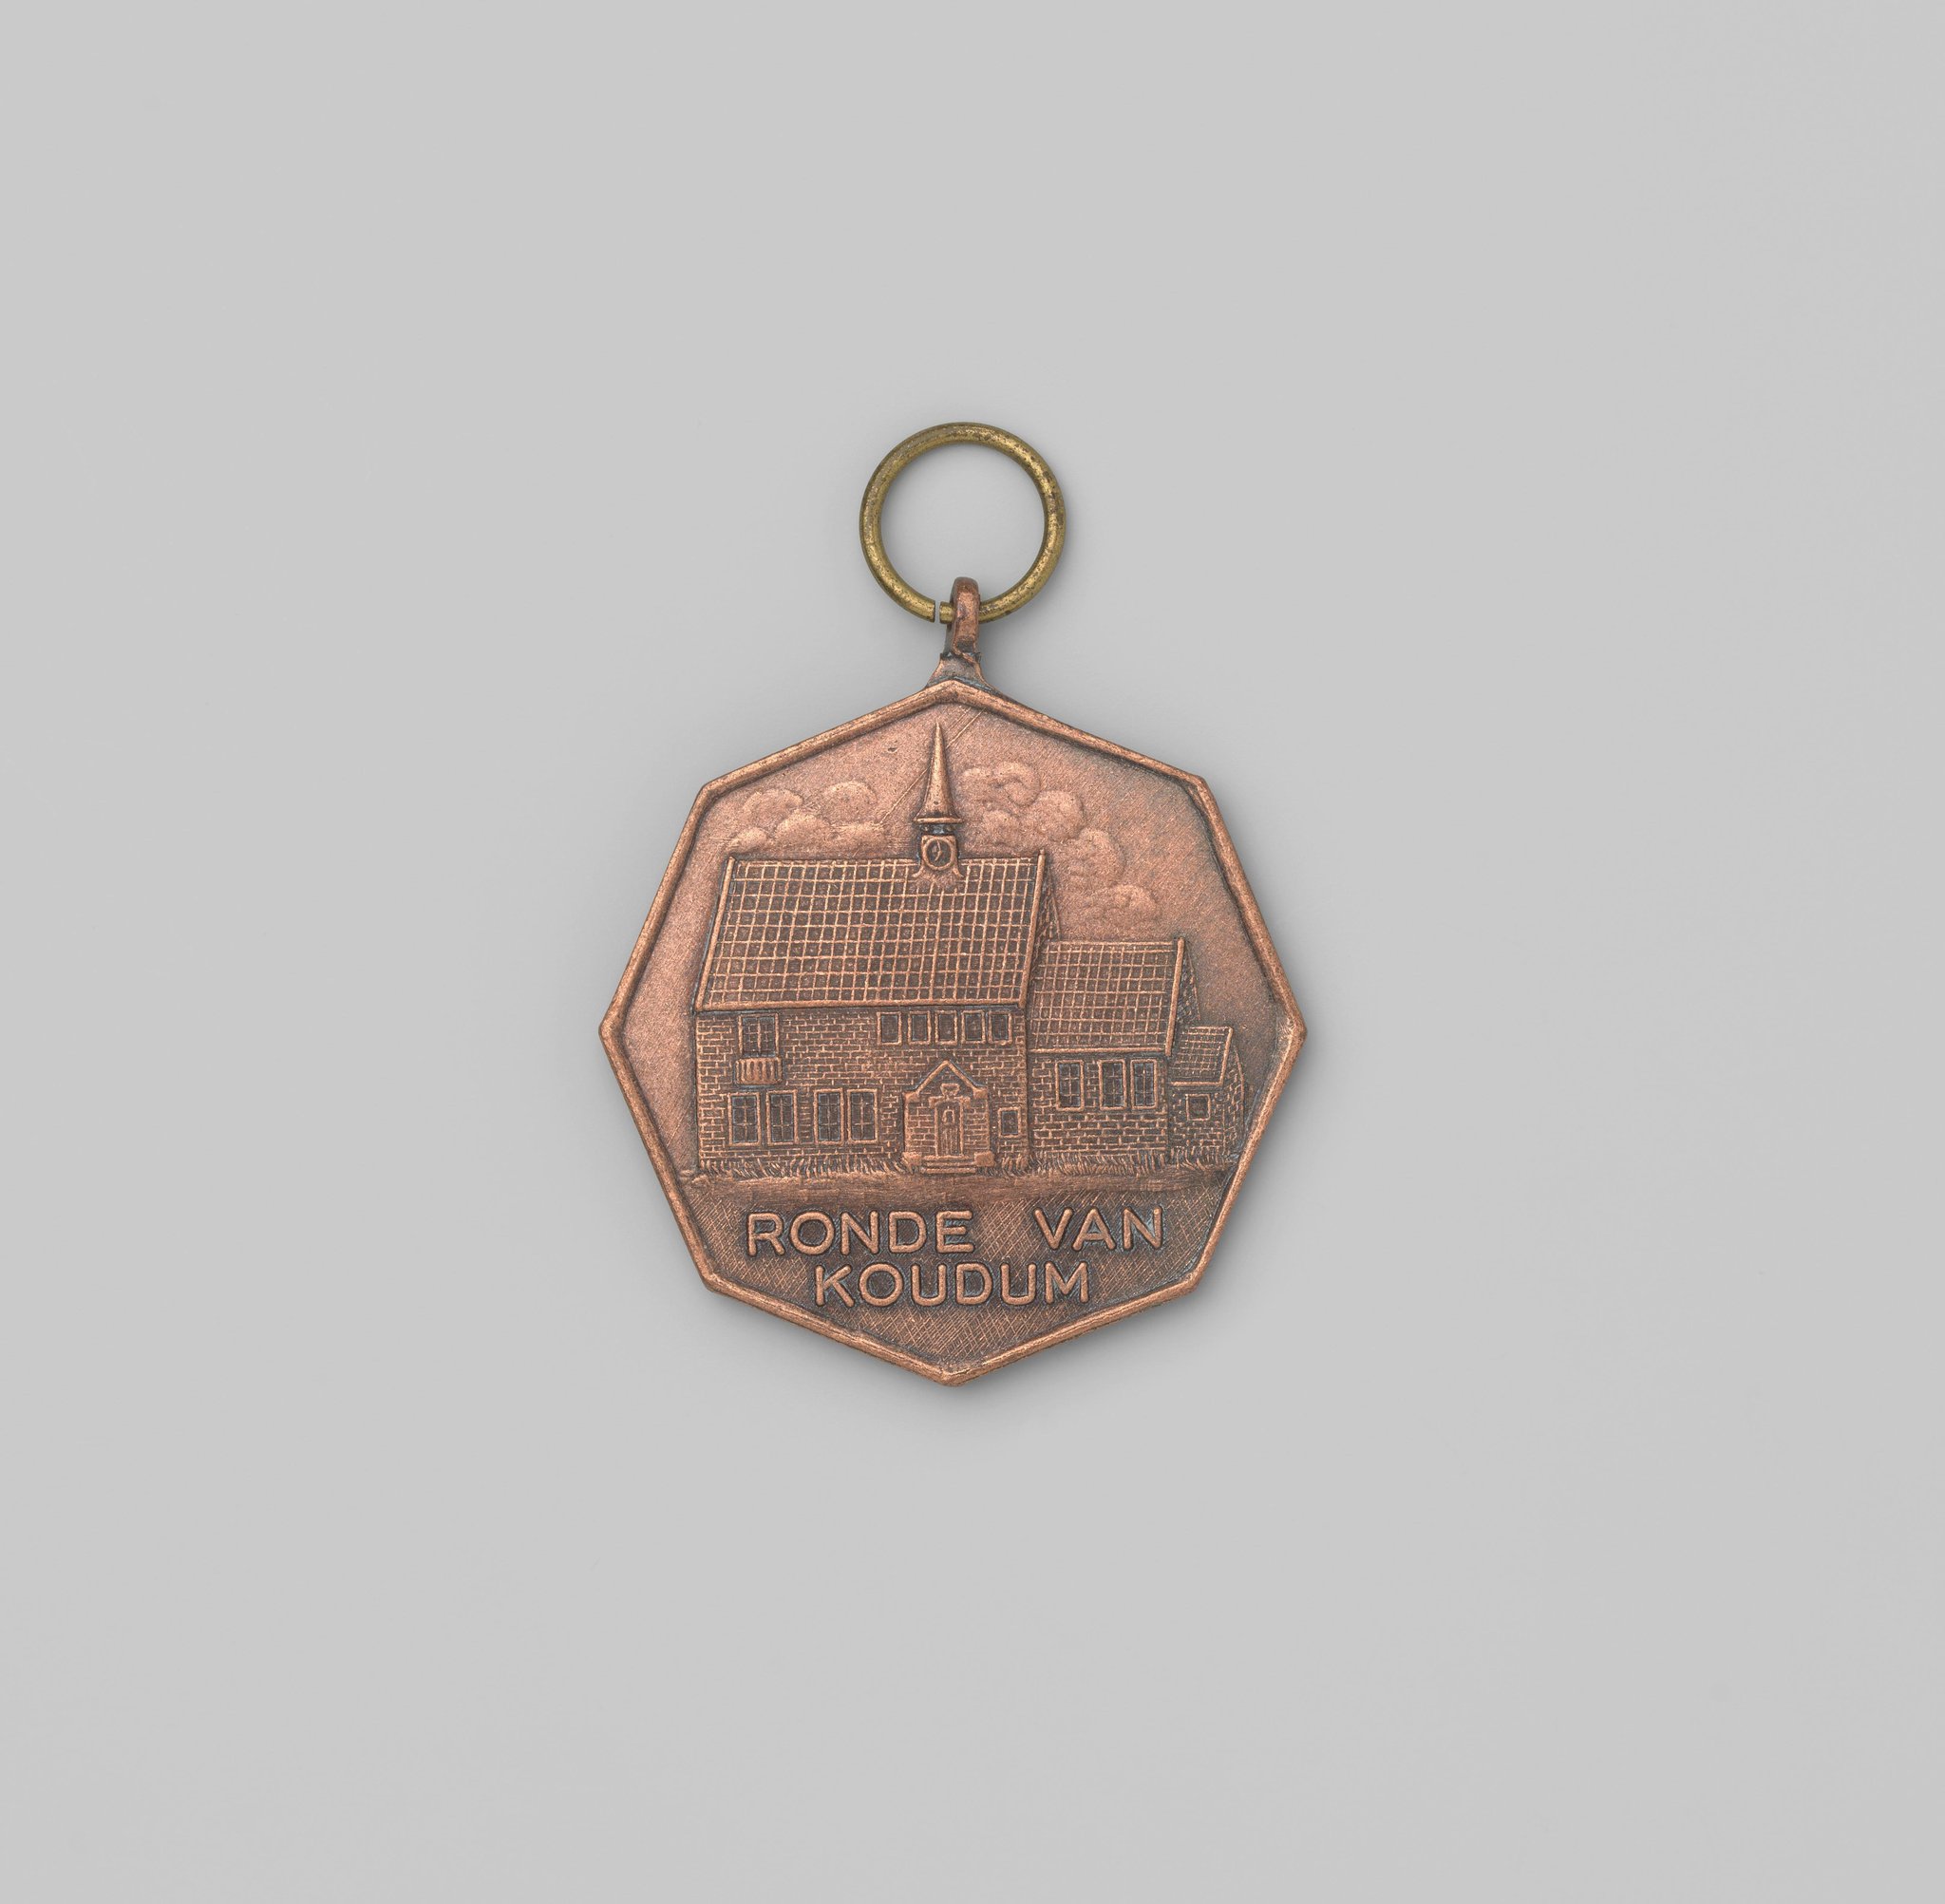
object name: onderscheidingsteken, onderscheiding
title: Onderscheiding Ronde van Koudum 1985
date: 1985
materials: metal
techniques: striking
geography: sneek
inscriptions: inscription: ‘IJssportvereniging Koudum 12-1-85’